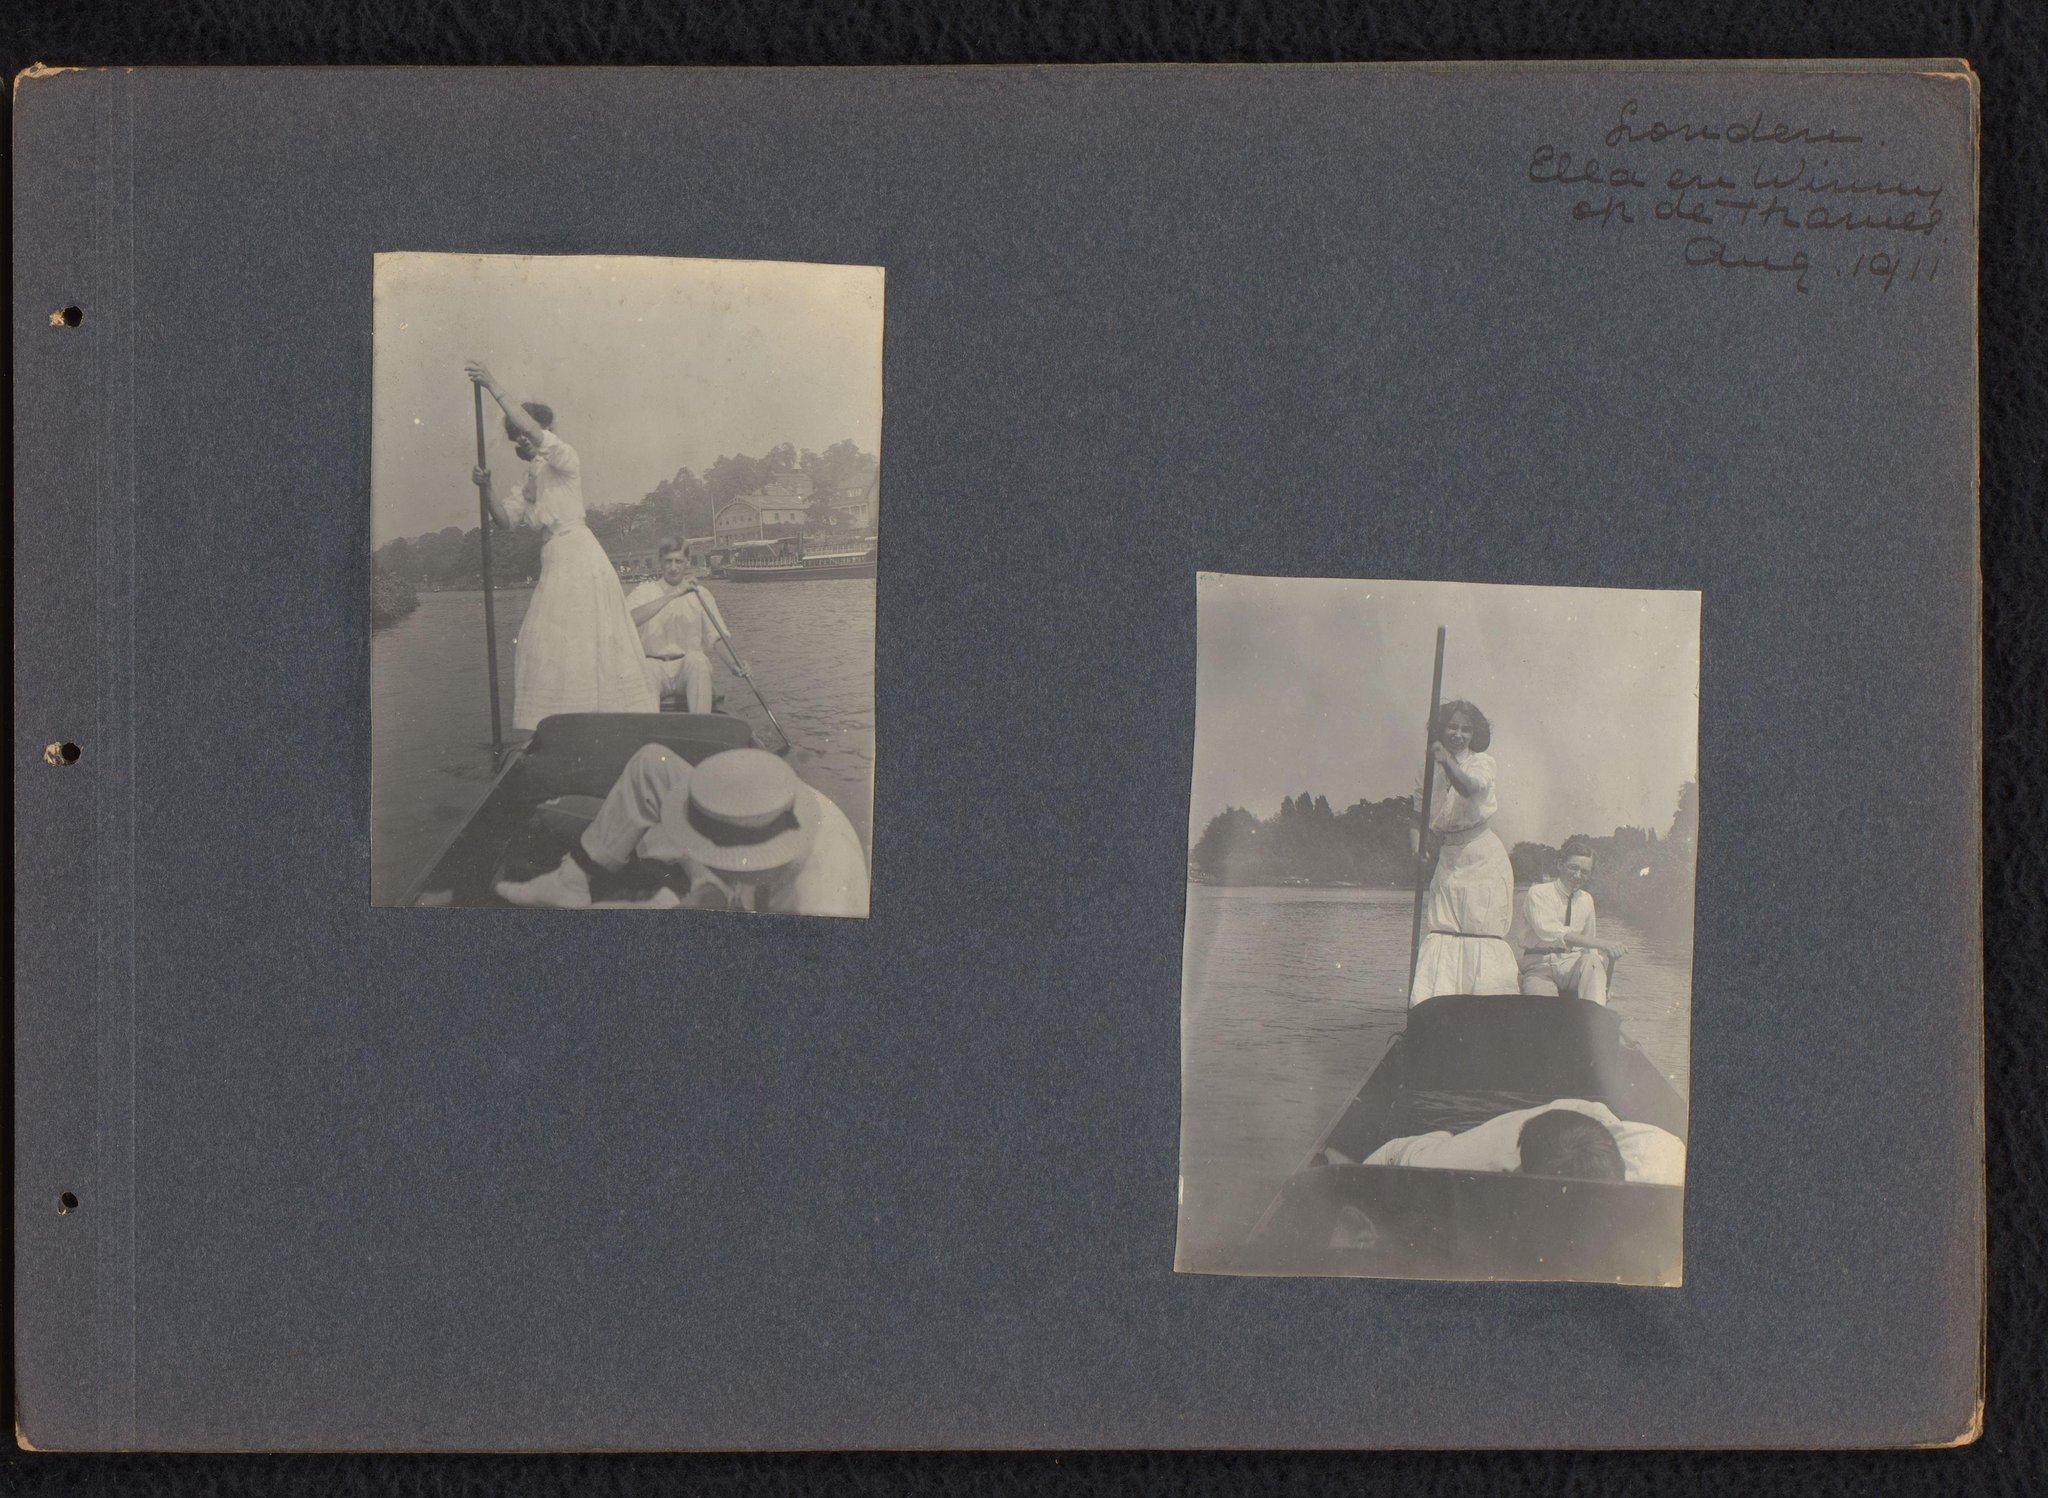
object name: album leaf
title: Drie mensen in een roeiboot op de Theems, waaronder Ella en Winny Uhlenbeck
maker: carolina frederika onnen (lien/loen)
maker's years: 1896-1983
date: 1908-1911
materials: paper, cardboard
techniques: gelatin silver print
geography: london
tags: rowing-boat, canoe, etc., thames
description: Deze foto's zijn onderdeel van een album.